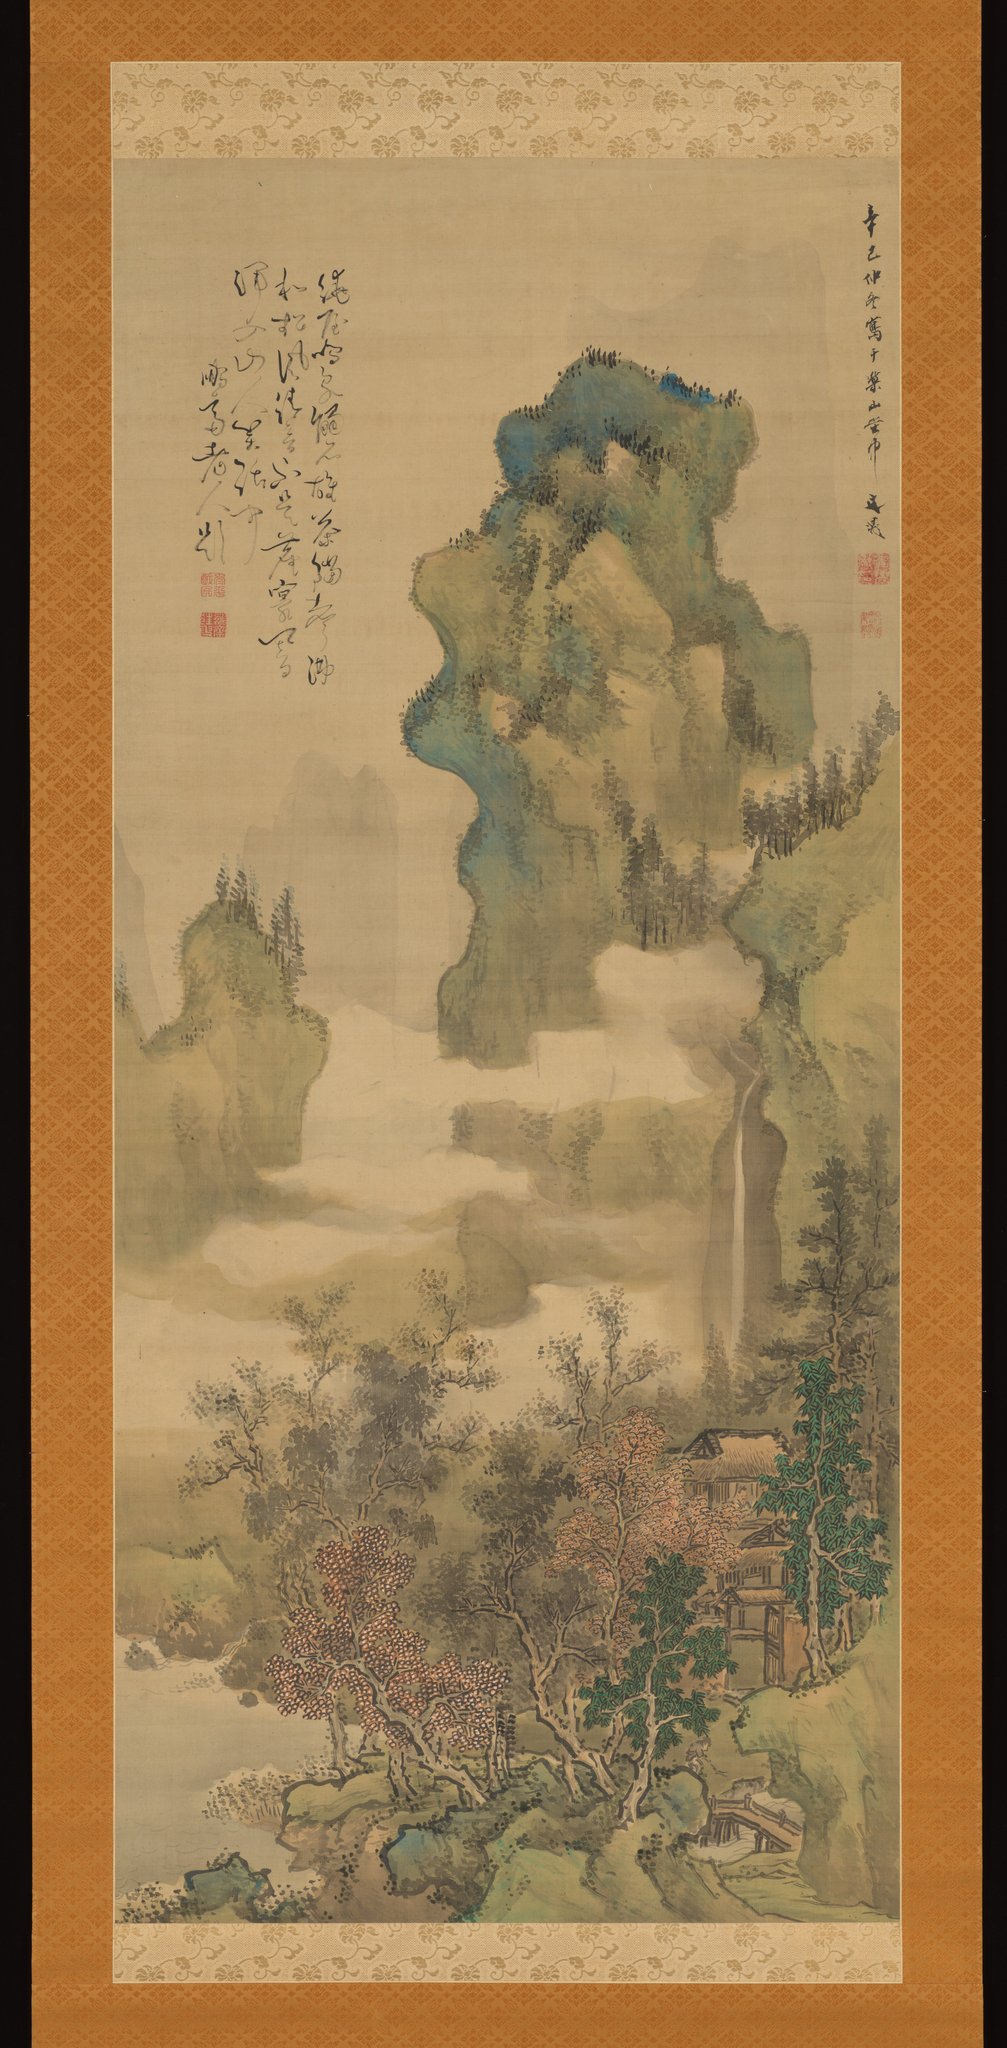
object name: hanging scroll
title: Quiet Residence in an Autumn Valley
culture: japanese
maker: tani bunchō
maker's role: artist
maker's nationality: japanese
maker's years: 1763-1840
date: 1821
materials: ink, silk